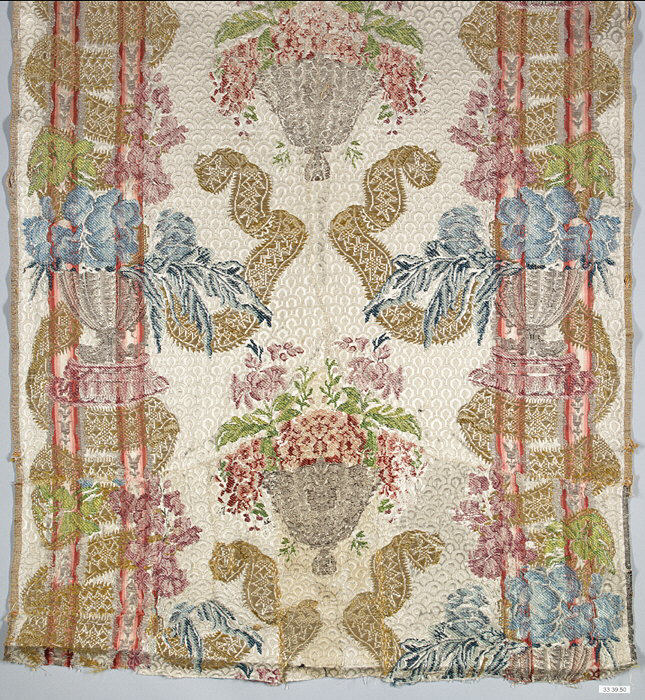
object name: piece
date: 1735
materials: metal thread, silk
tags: flowers